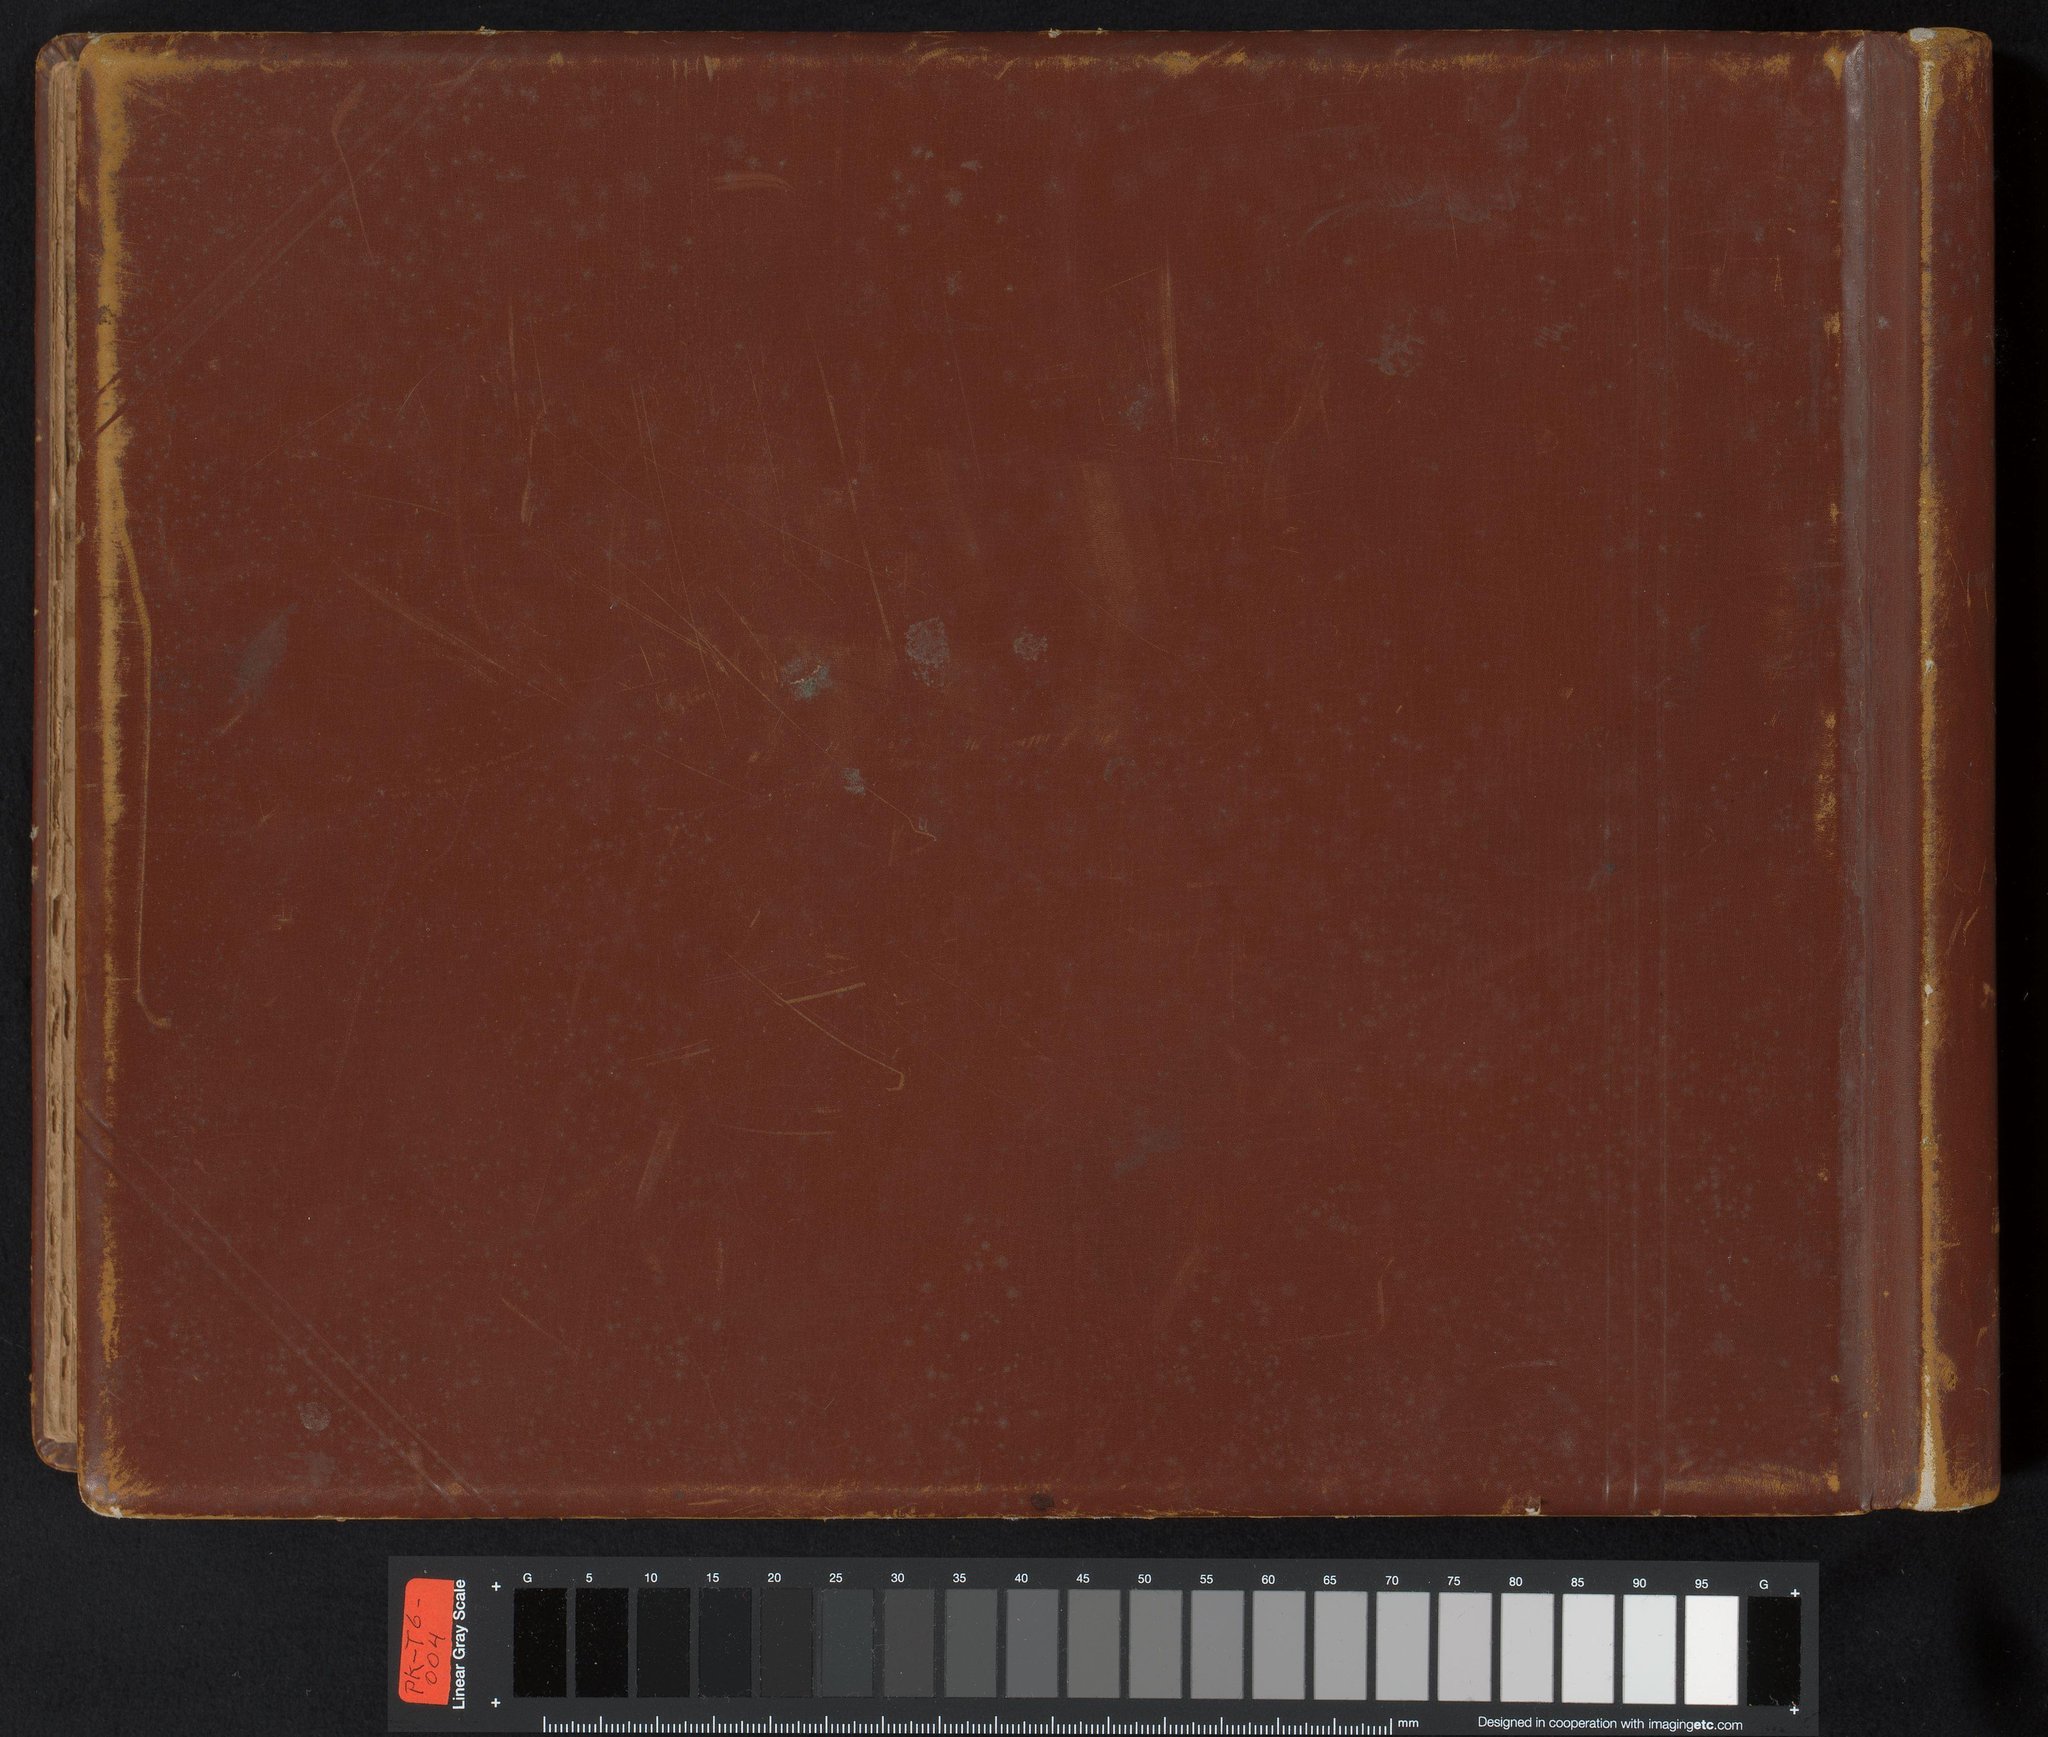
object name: photograph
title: Theefabriek Kertamanah gebouwd door Machinefabriek Braat Soerabaia 1934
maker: Anonymous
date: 1934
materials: cardboard, photographic support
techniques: gelatin silver print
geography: bandung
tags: factory-interior, machine shop, java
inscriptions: date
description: Albumblad met een foto van het interieur van de theefabriek Kertamanah. Onderdeel van een fotoalbum met foto's van machines en constructies van de N.V. Machinefabriek Braat te Soerabaja, Soekaboemi en Tegal uit de periode 1931-1937.